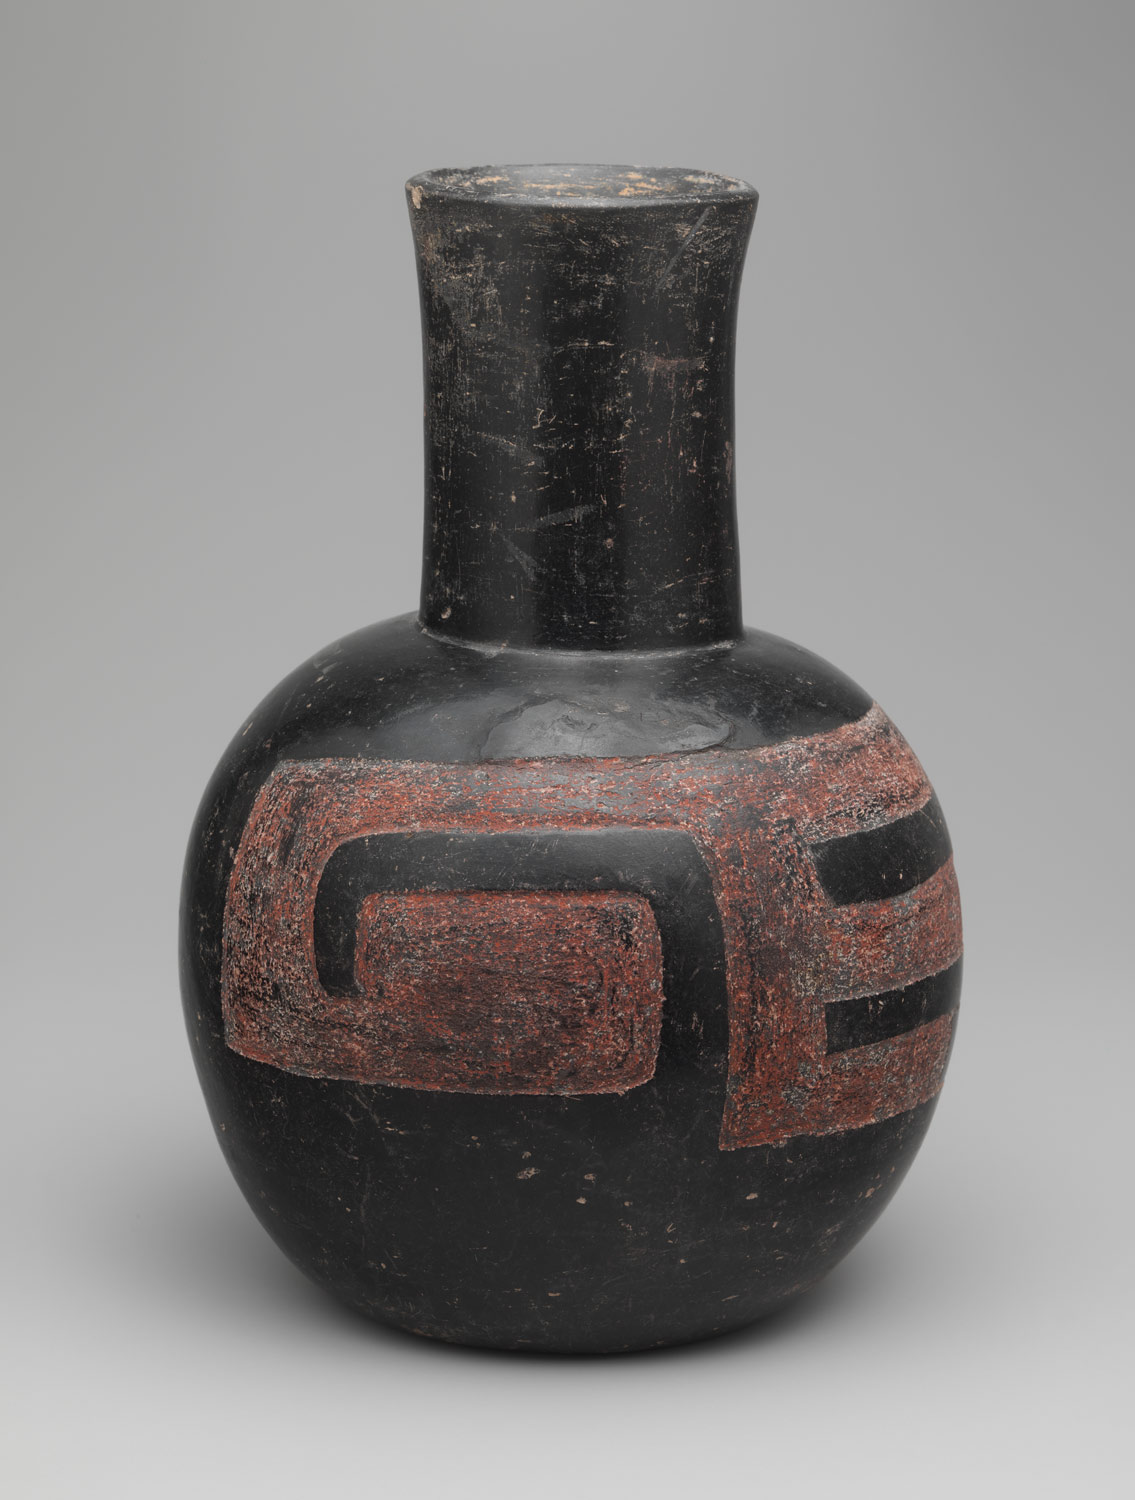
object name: bottle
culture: olmec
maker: central highlands artist(s)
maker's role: artist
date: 1200-800 BCE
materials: ceramic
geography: mexico